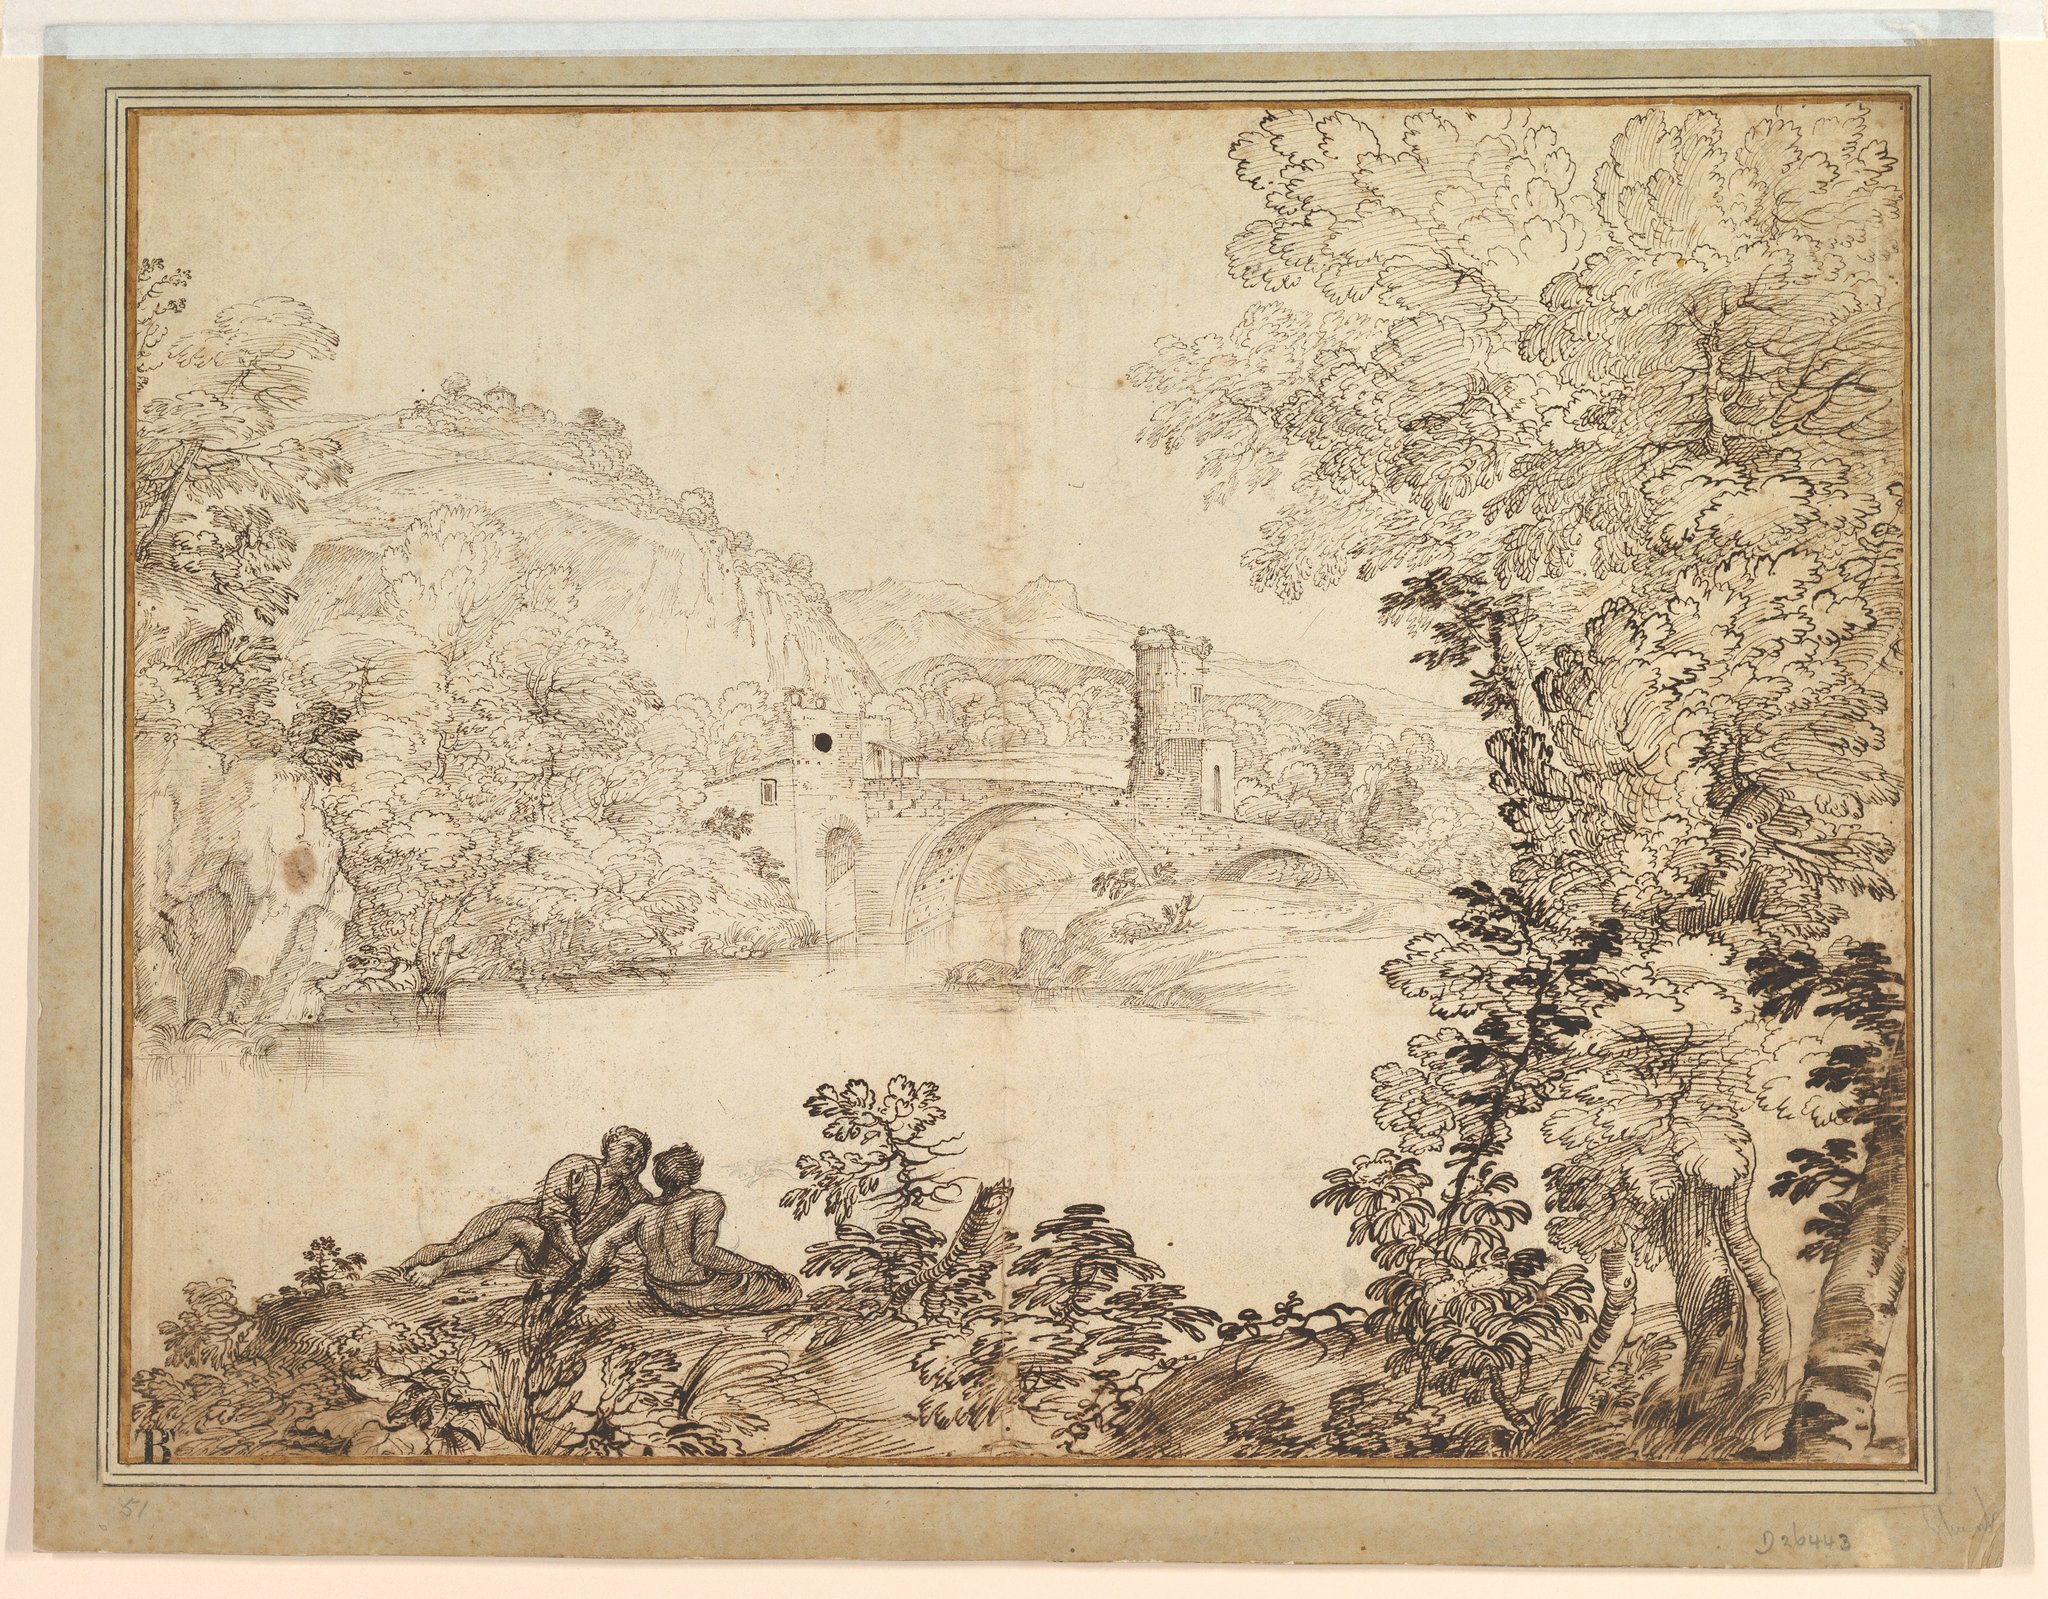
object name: drawing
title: Landscape with a Bridge and Two Figures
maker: giovanni francesco grimaldi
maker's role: artist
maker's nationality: italian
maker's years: 1606-1680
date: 1606-1680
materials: chalk, ink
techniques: pen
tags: bridges,landscapes